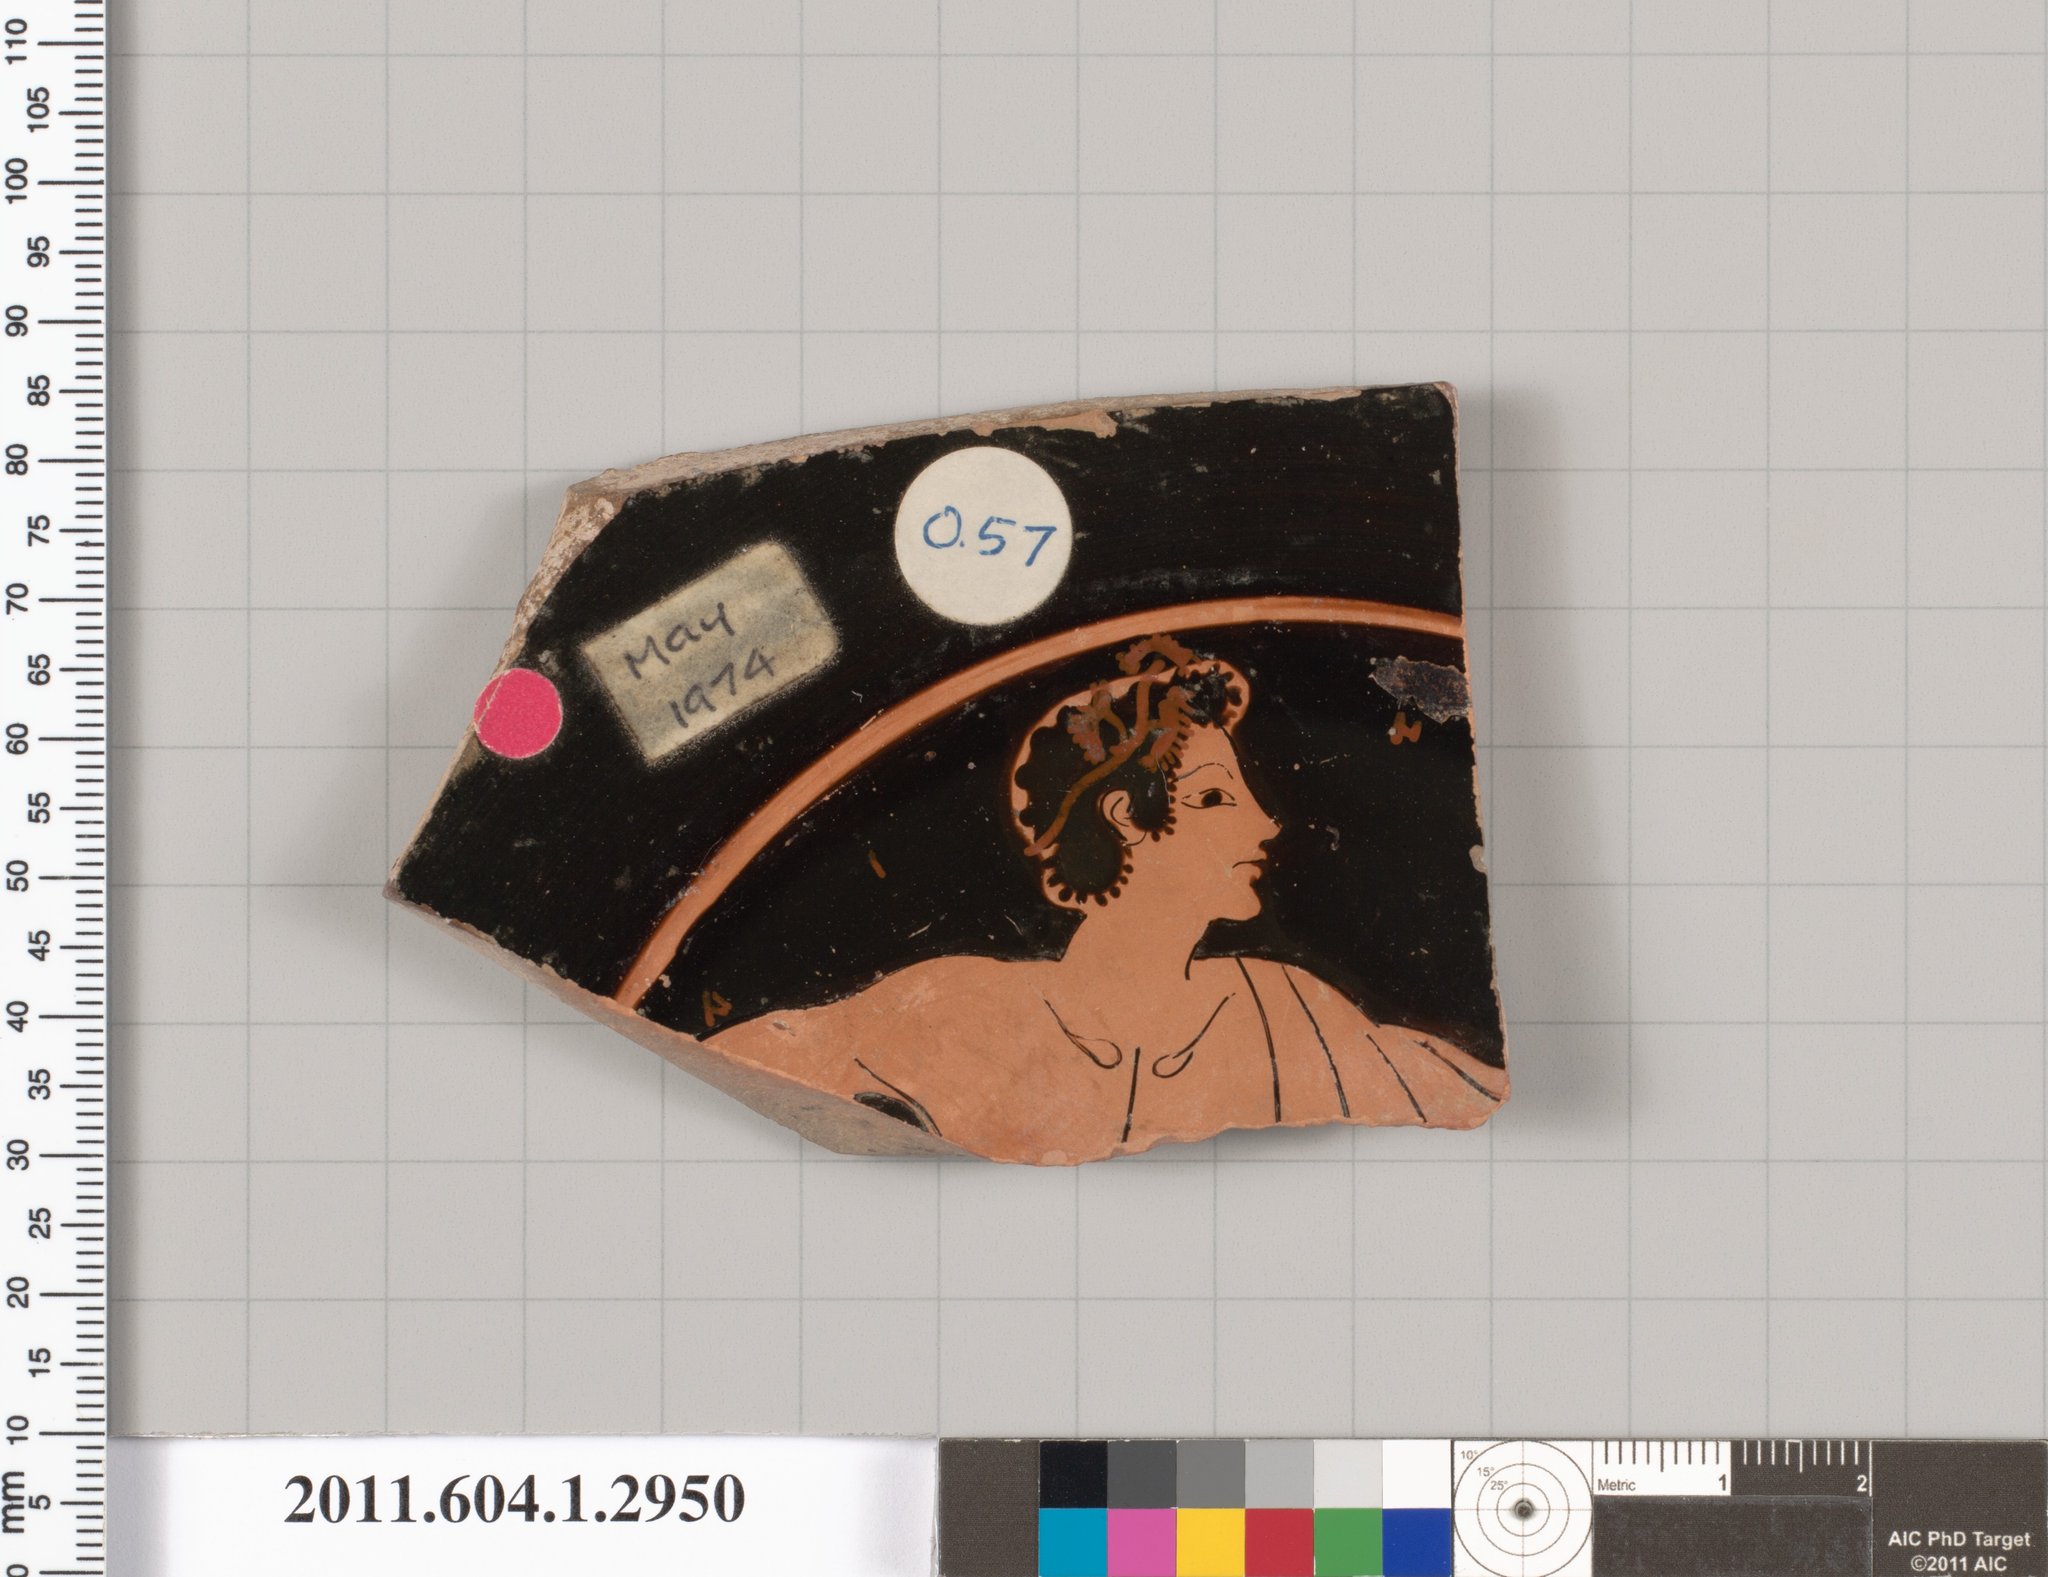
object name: kylix fragment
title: Terracotta fragment of a kylix (drinking cup)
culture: greek, attic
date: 520-500 BCE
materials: terracotta